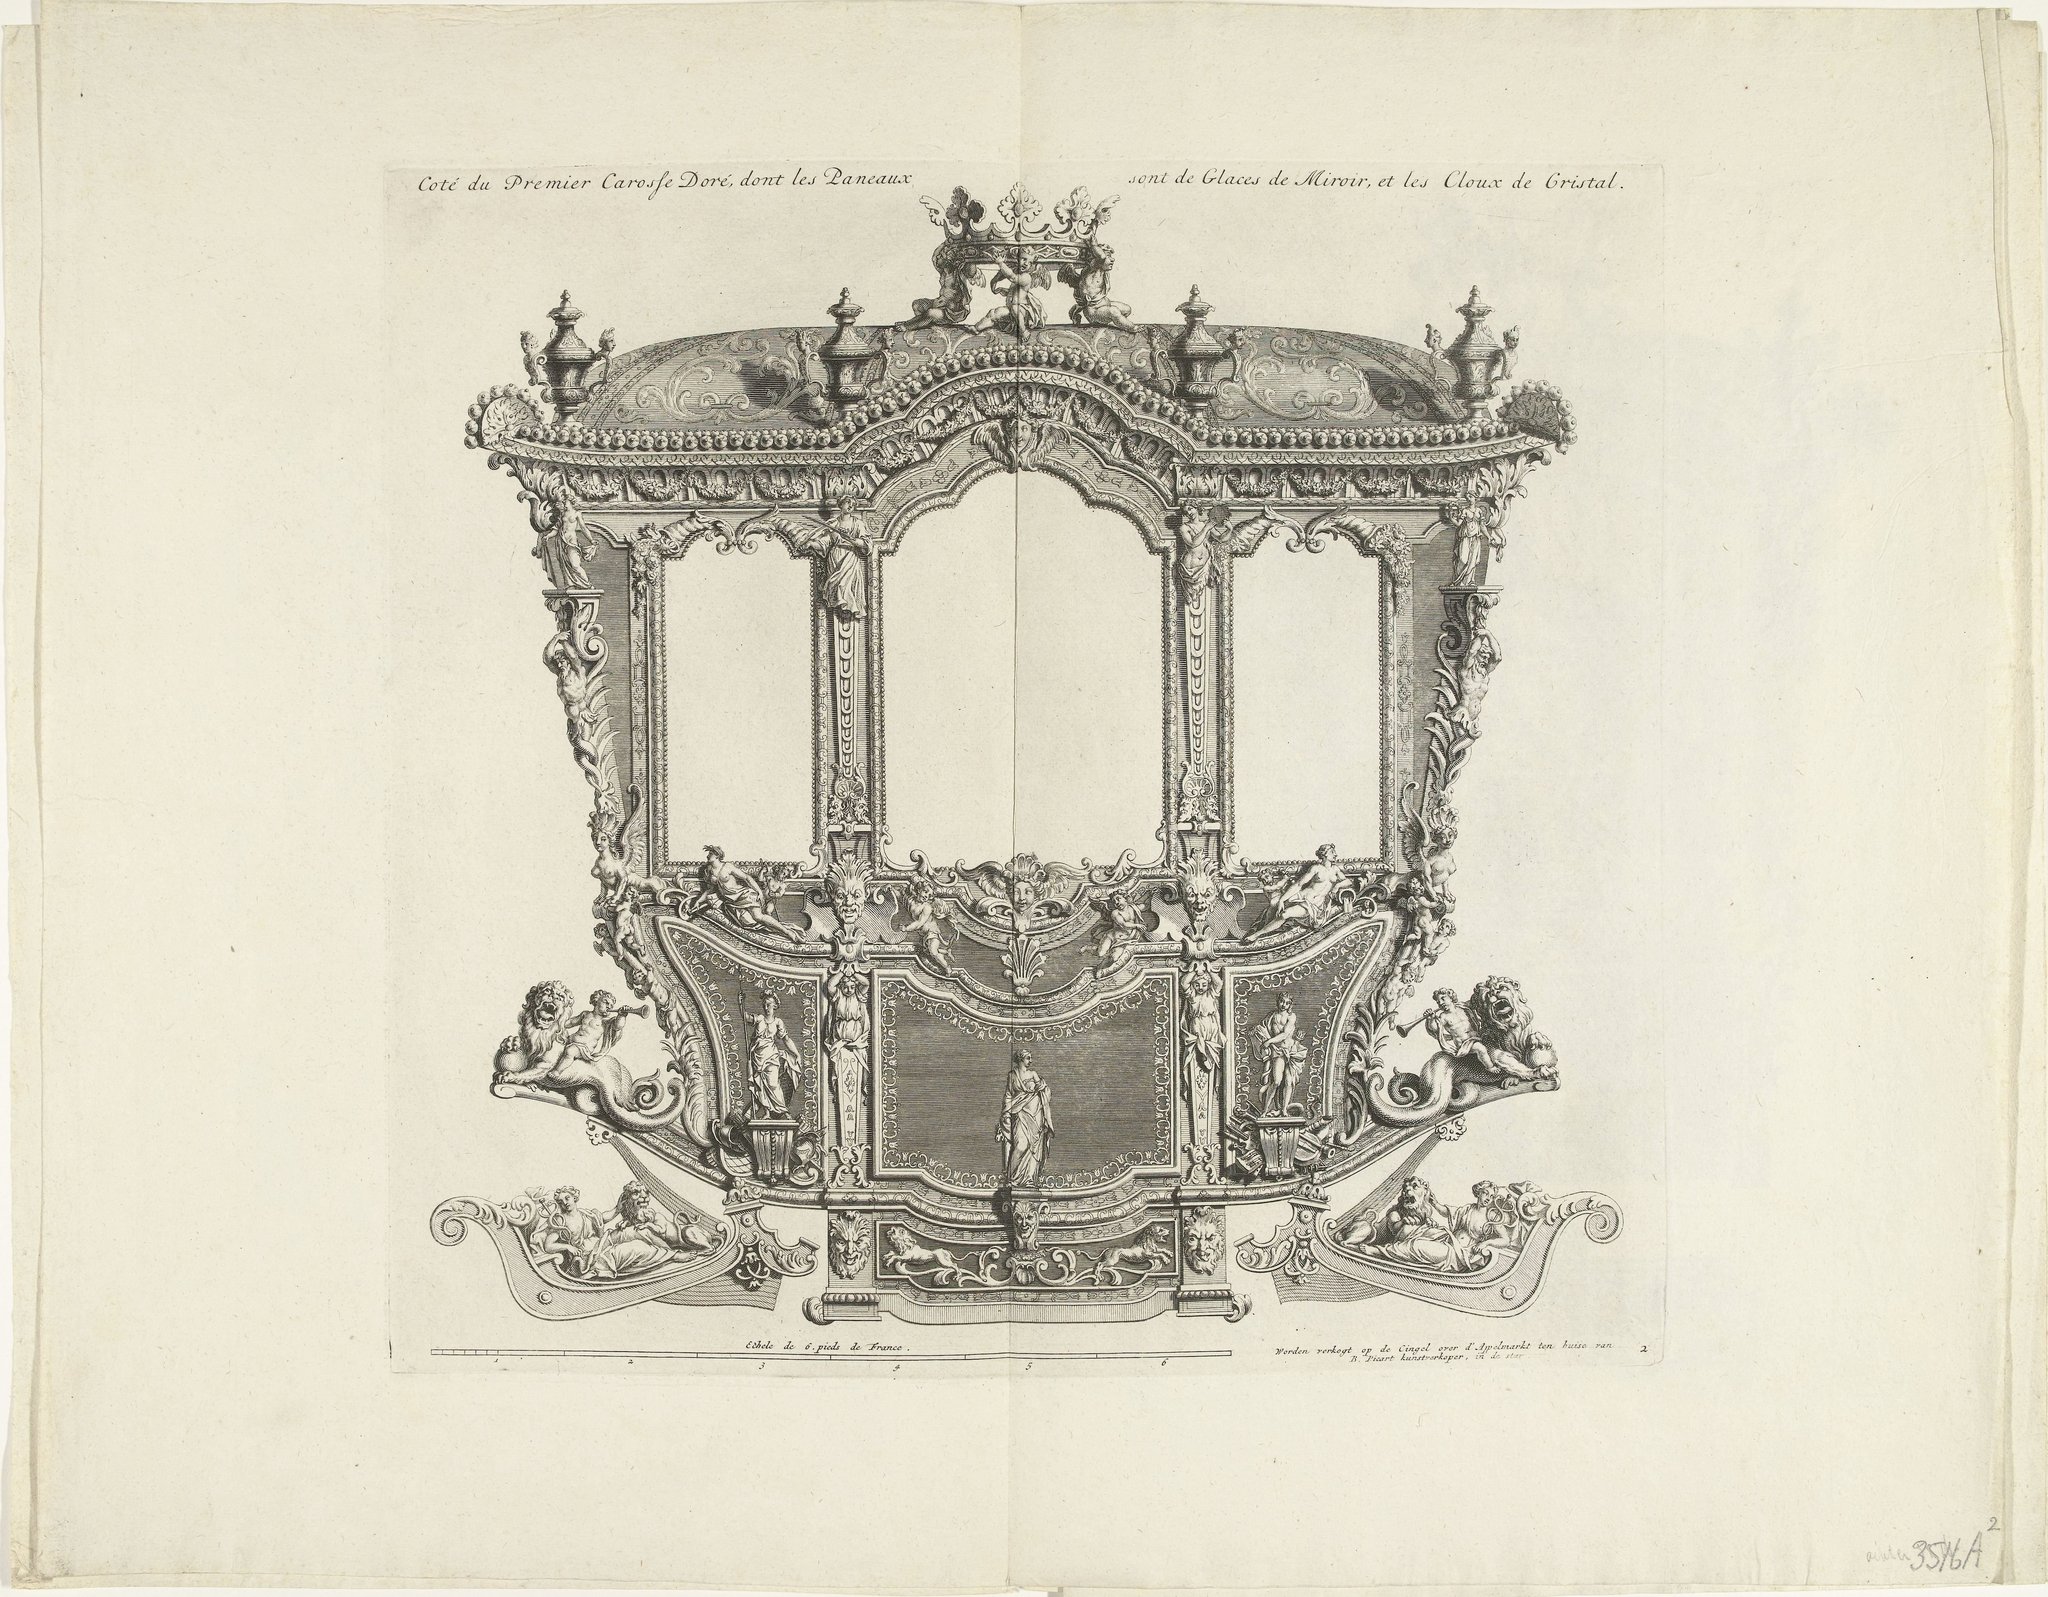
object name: print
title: Statiekoets van de hertog van Ossuna, 1713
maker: bernard picart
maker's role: draughtsman, print maker, publisher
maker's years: 1673-1733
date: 1714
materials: paper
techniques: engraving, etching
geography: amsterdam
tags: four-wheeled, animal-drawn vehicle, e.g.: cab, carriage, coach, utrecht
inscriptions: collector's mark: Lugt 2228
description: Zijkant van de gouden koets met panelen van spiegelend glas en kristal. Onderdeel van een serie van 7 platen met de statiekoets van de Spaanse gezant de hertog van Ossuna, gebruikt bij zijn openbare intocht in Utrecht voor de vredesonderhandelingen in 1713. Genummerd rechtsonder: 2.